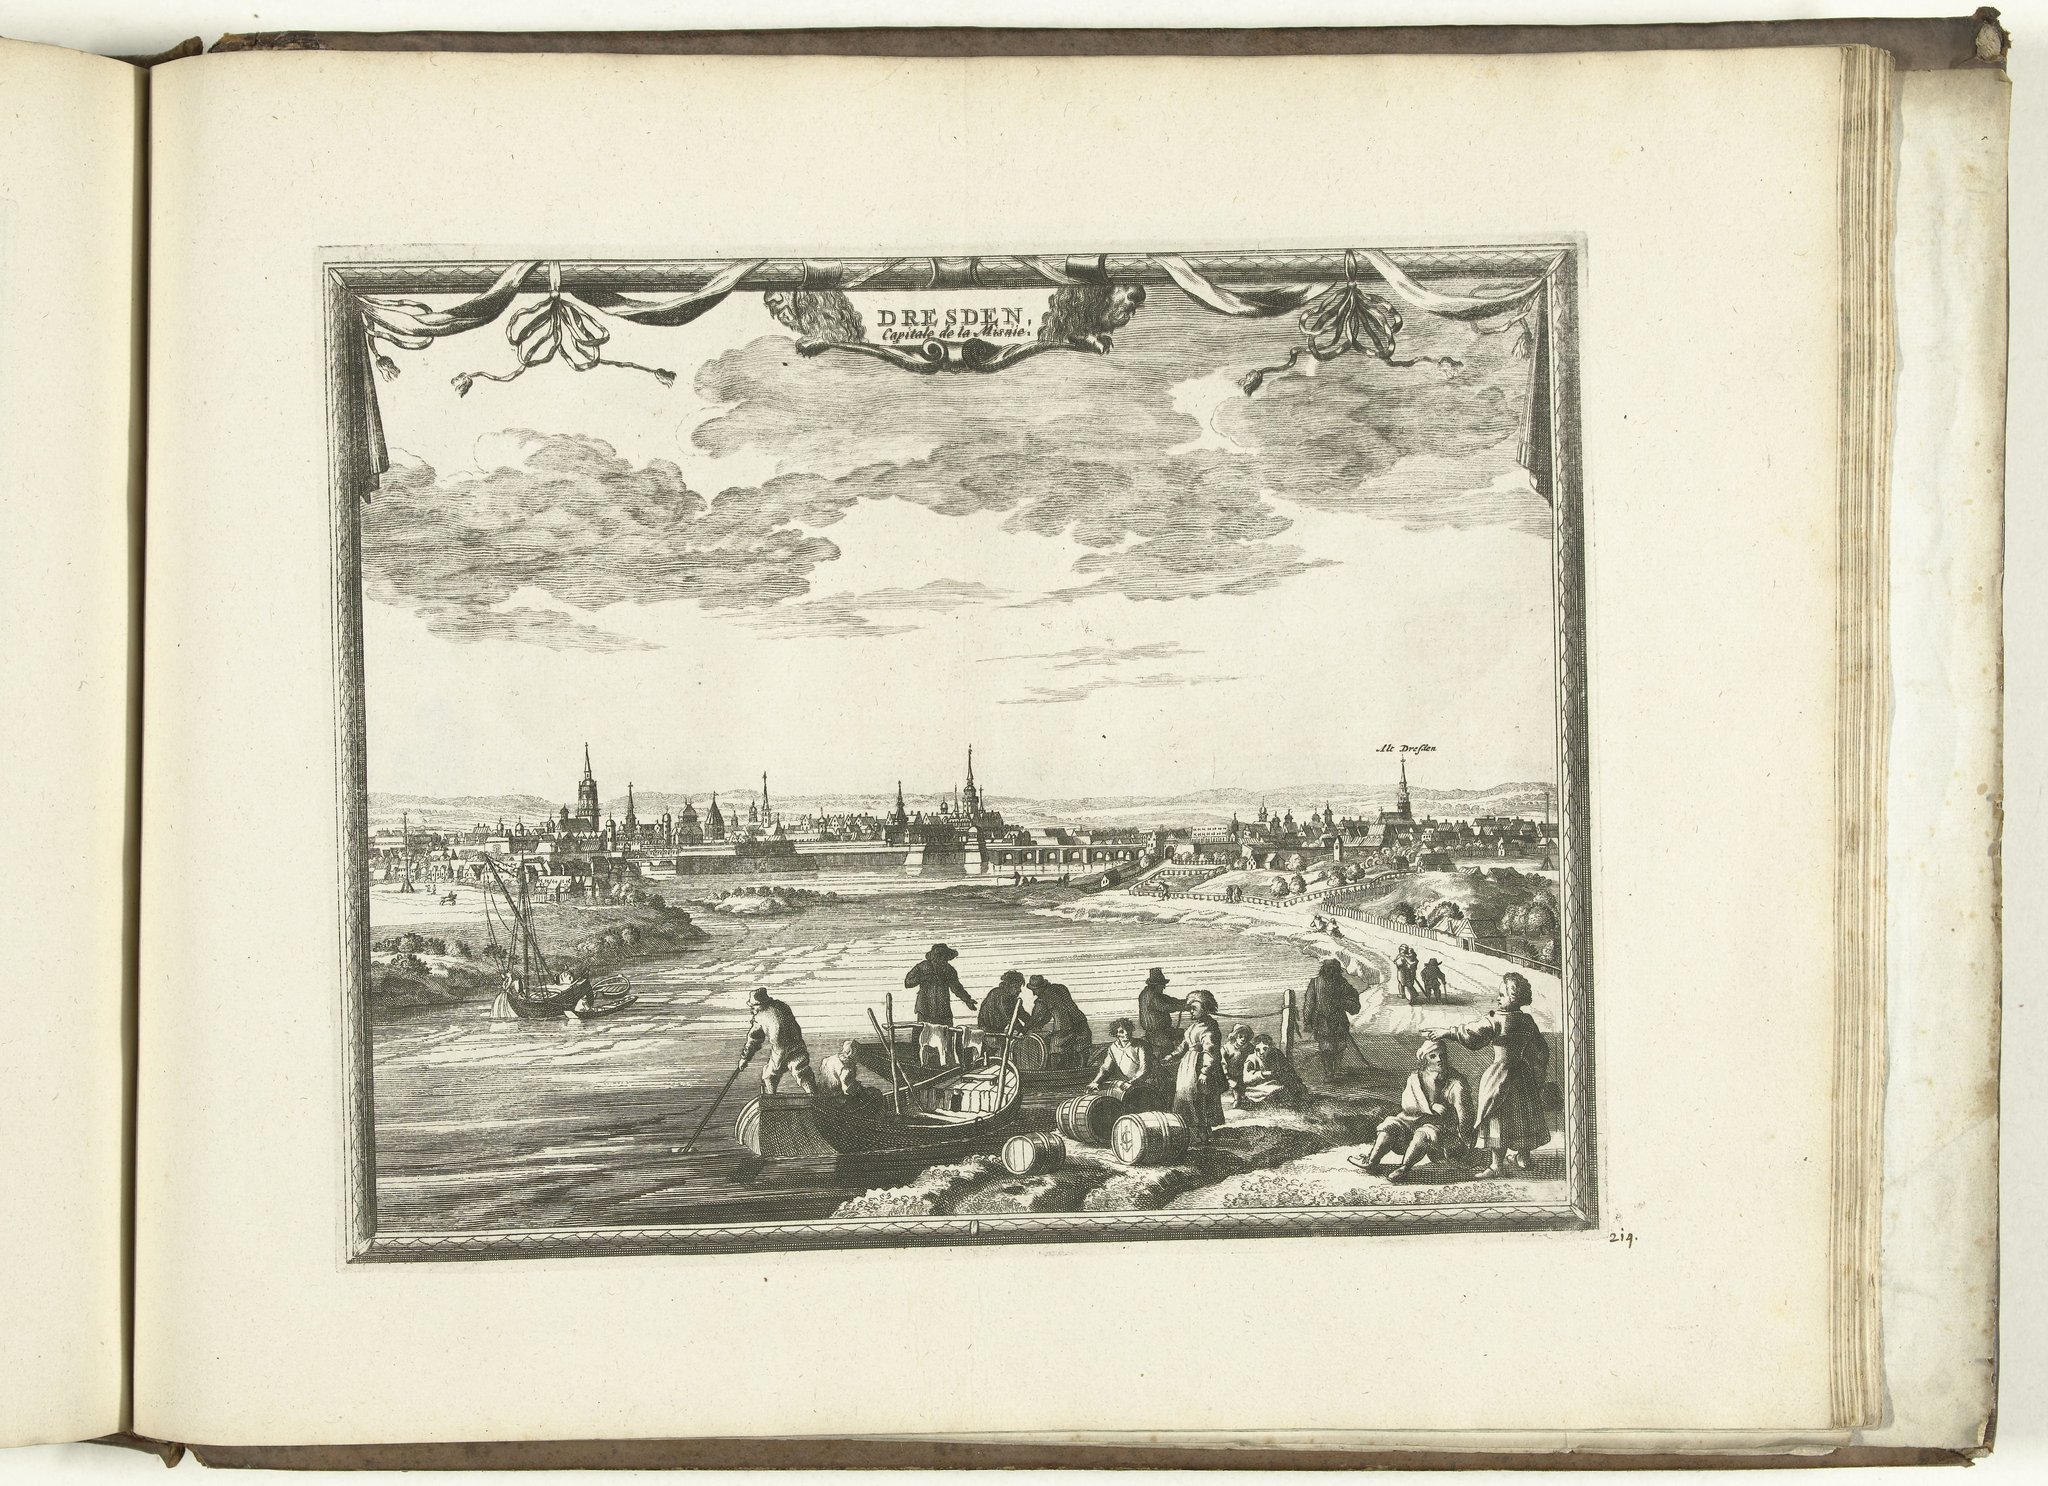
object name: print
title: Dresden, Capitale de la Misnie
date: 1726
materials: paper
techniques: etching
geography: northern netherlands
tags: dresden, spaanse successieoorlog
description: Gezicht op Dresden, op de voorgrond worden twee bootjes uitgeladen. Plaat nr. 214 in deel IX van het prentwerk: Les Forces de l'Europe, Asie, Afrique et Amerique ... Comme aussi les Cartes des Côtes de France et d'Espagne uit 1726, dit eerste deel met 238 met de hand genummerde platen van vermaarde sterke steden en vestingen in het kader van de Spaanse Successieoorlog 1701-1713. Voor het merendeel zijn deze platen gekopieerd naar de anonieme Franse platen van vermaarde sterke steden en vestingen: in Les forces de l'Europe en in: Le theatre de la guerre, dans les Pays-Bas, beide oorspronkelijk uitgegeven door Nicolas de Fer te Parijs (1693-1697) in het kader van de Negenjarige Oorlog. Titel in het Frans.